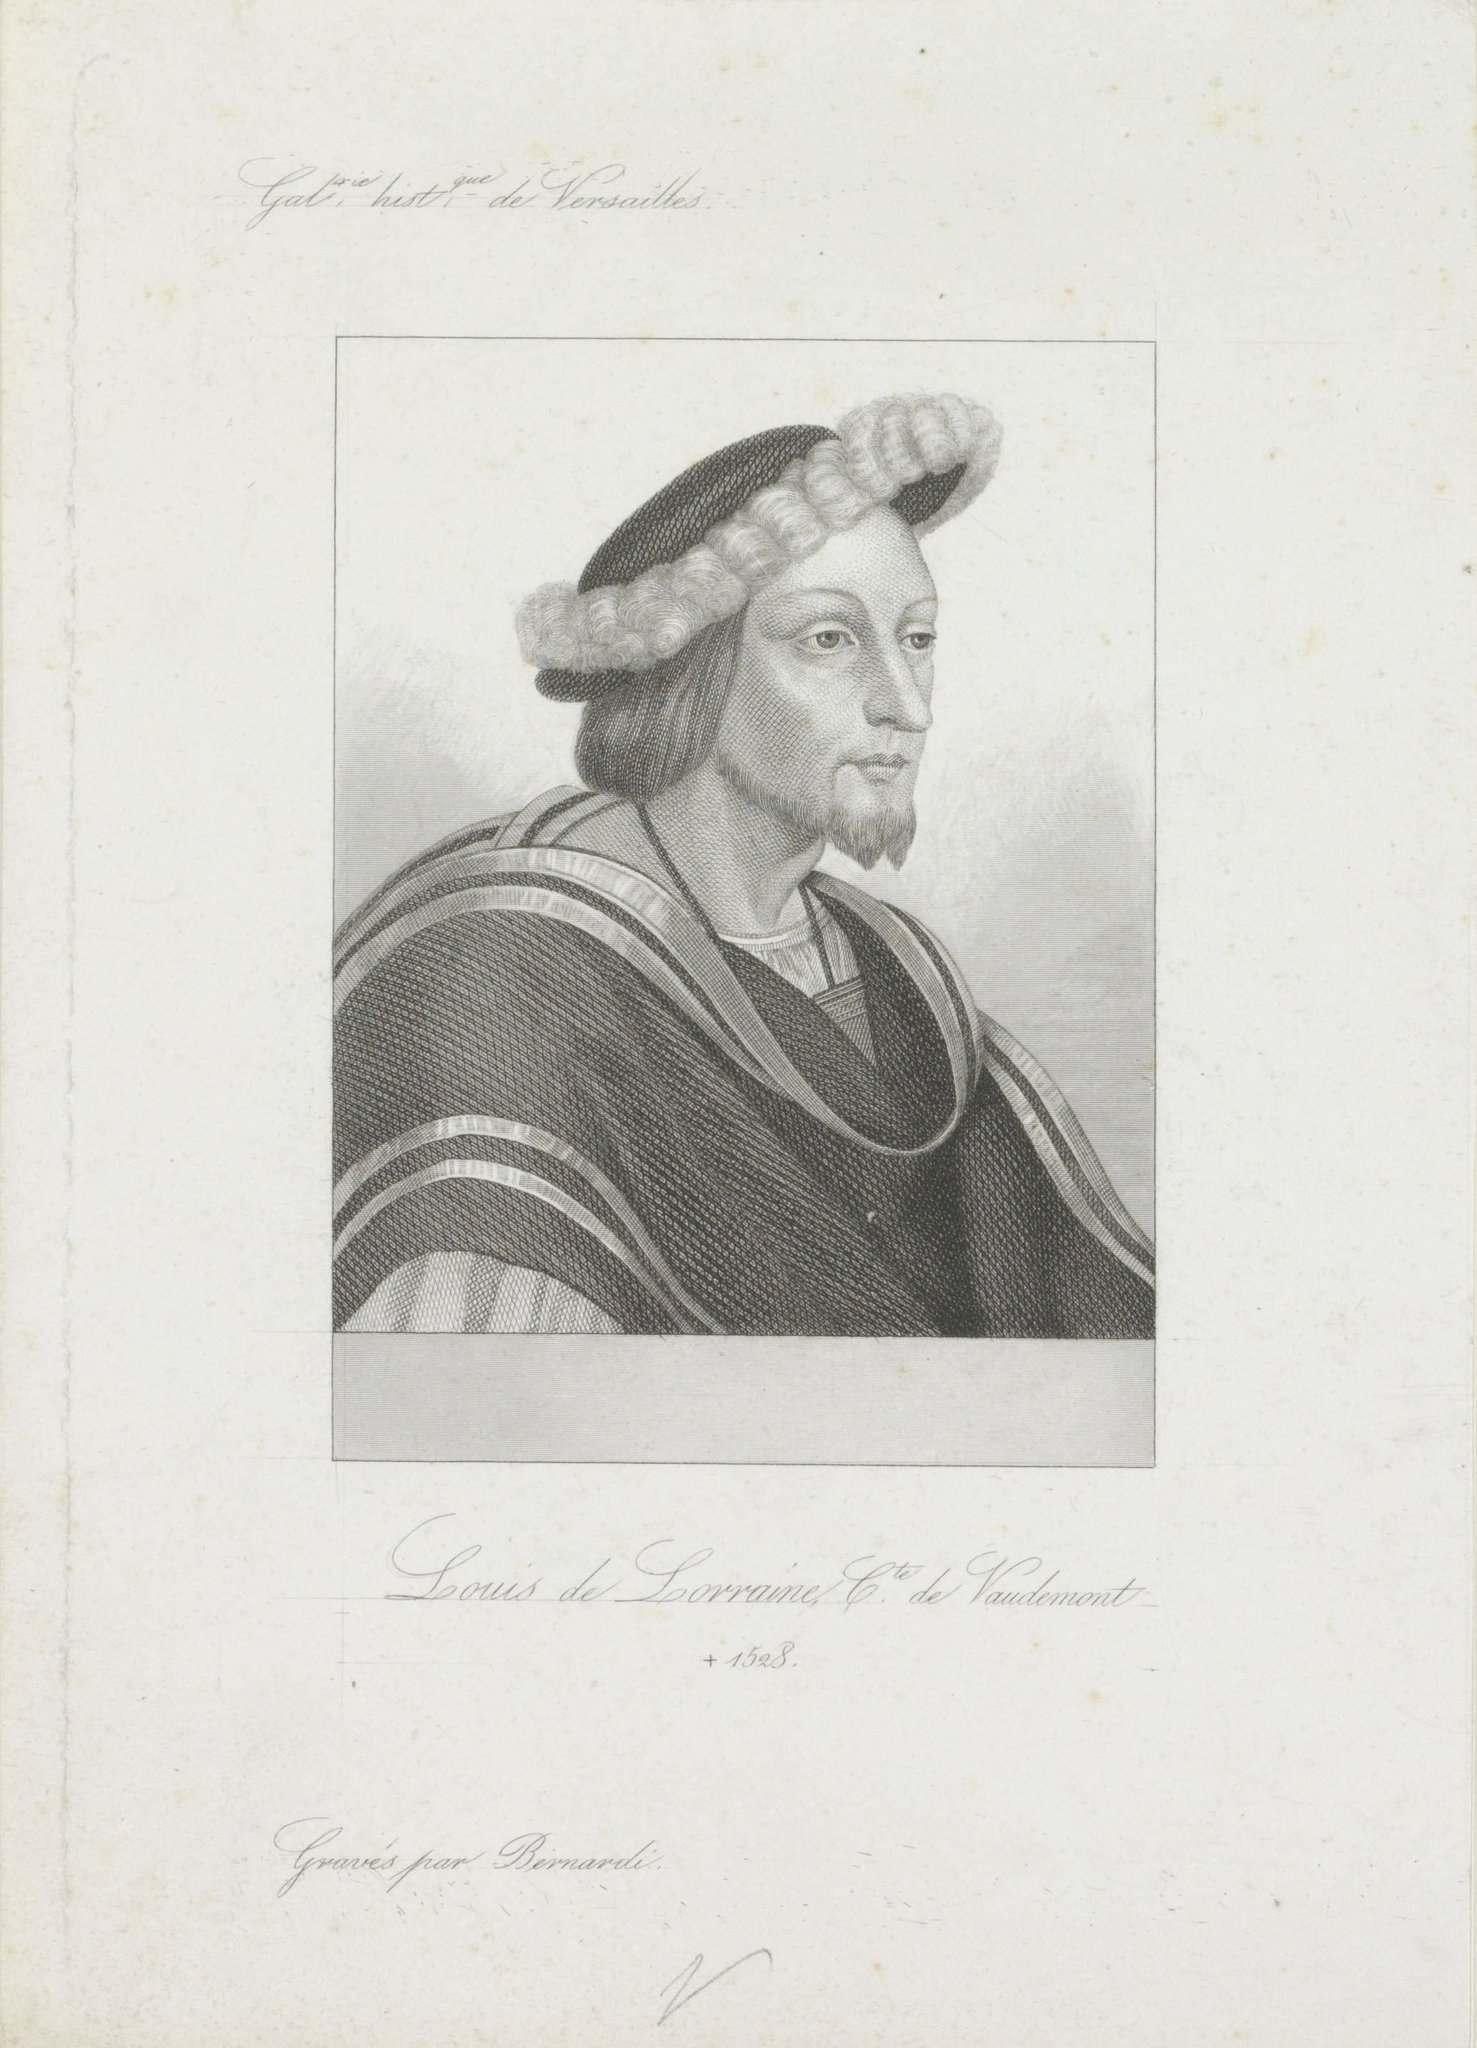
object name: print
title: Galerie historique de Versailles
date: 1818-1848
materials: paper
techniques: engraving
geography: paris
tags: earl, historical persons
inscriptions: collector's mark: Lugt 2228